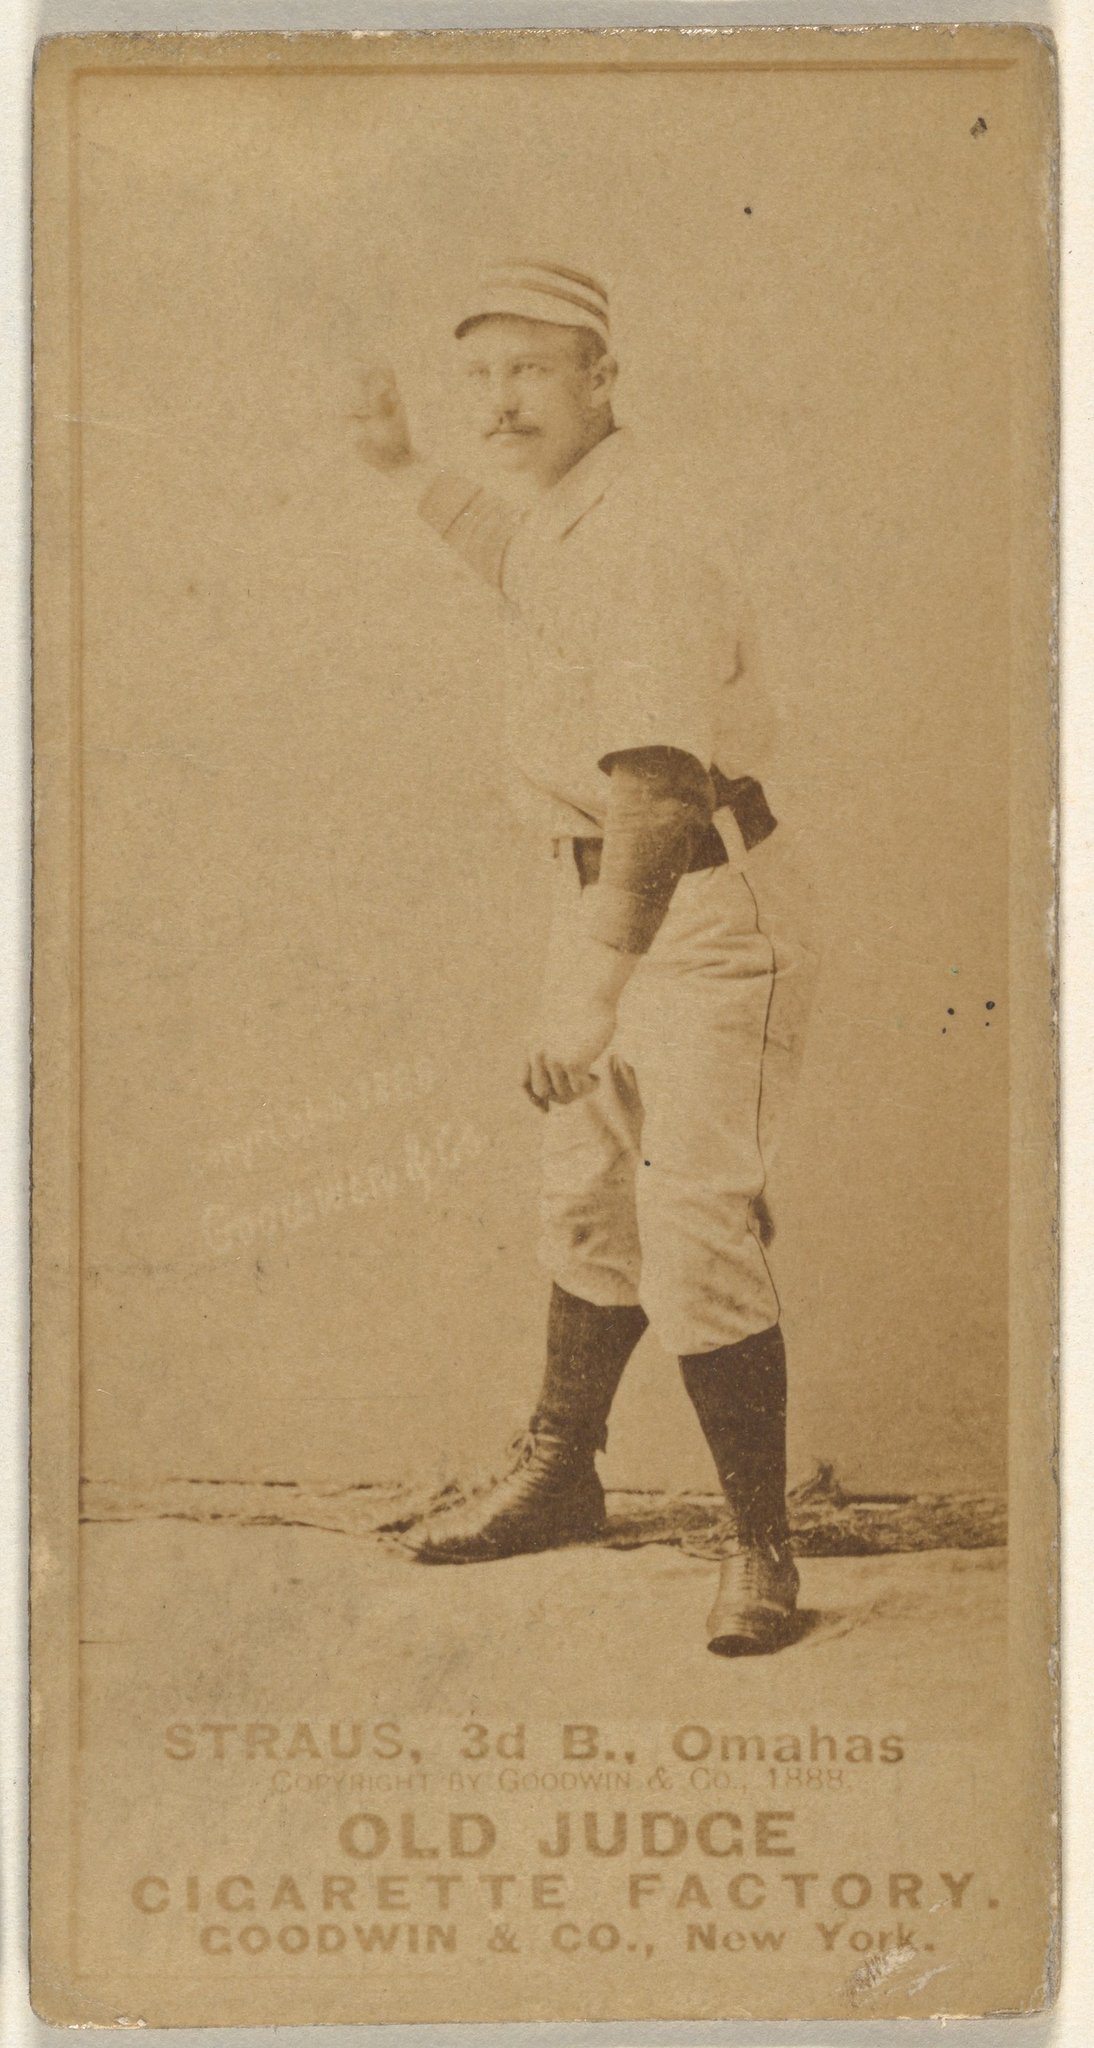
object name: baseball card, photograph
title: Joseph "Joe" Strauss, 3rd Base, Omaha Omahogs/ Lambs, from the Old Judge series (N172) for Old Judge Cigarettes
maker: goodwin & company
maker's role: publisher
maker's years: 1850-1950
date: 1888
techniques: albumen silver print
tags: men,portraits,baseball,athletes